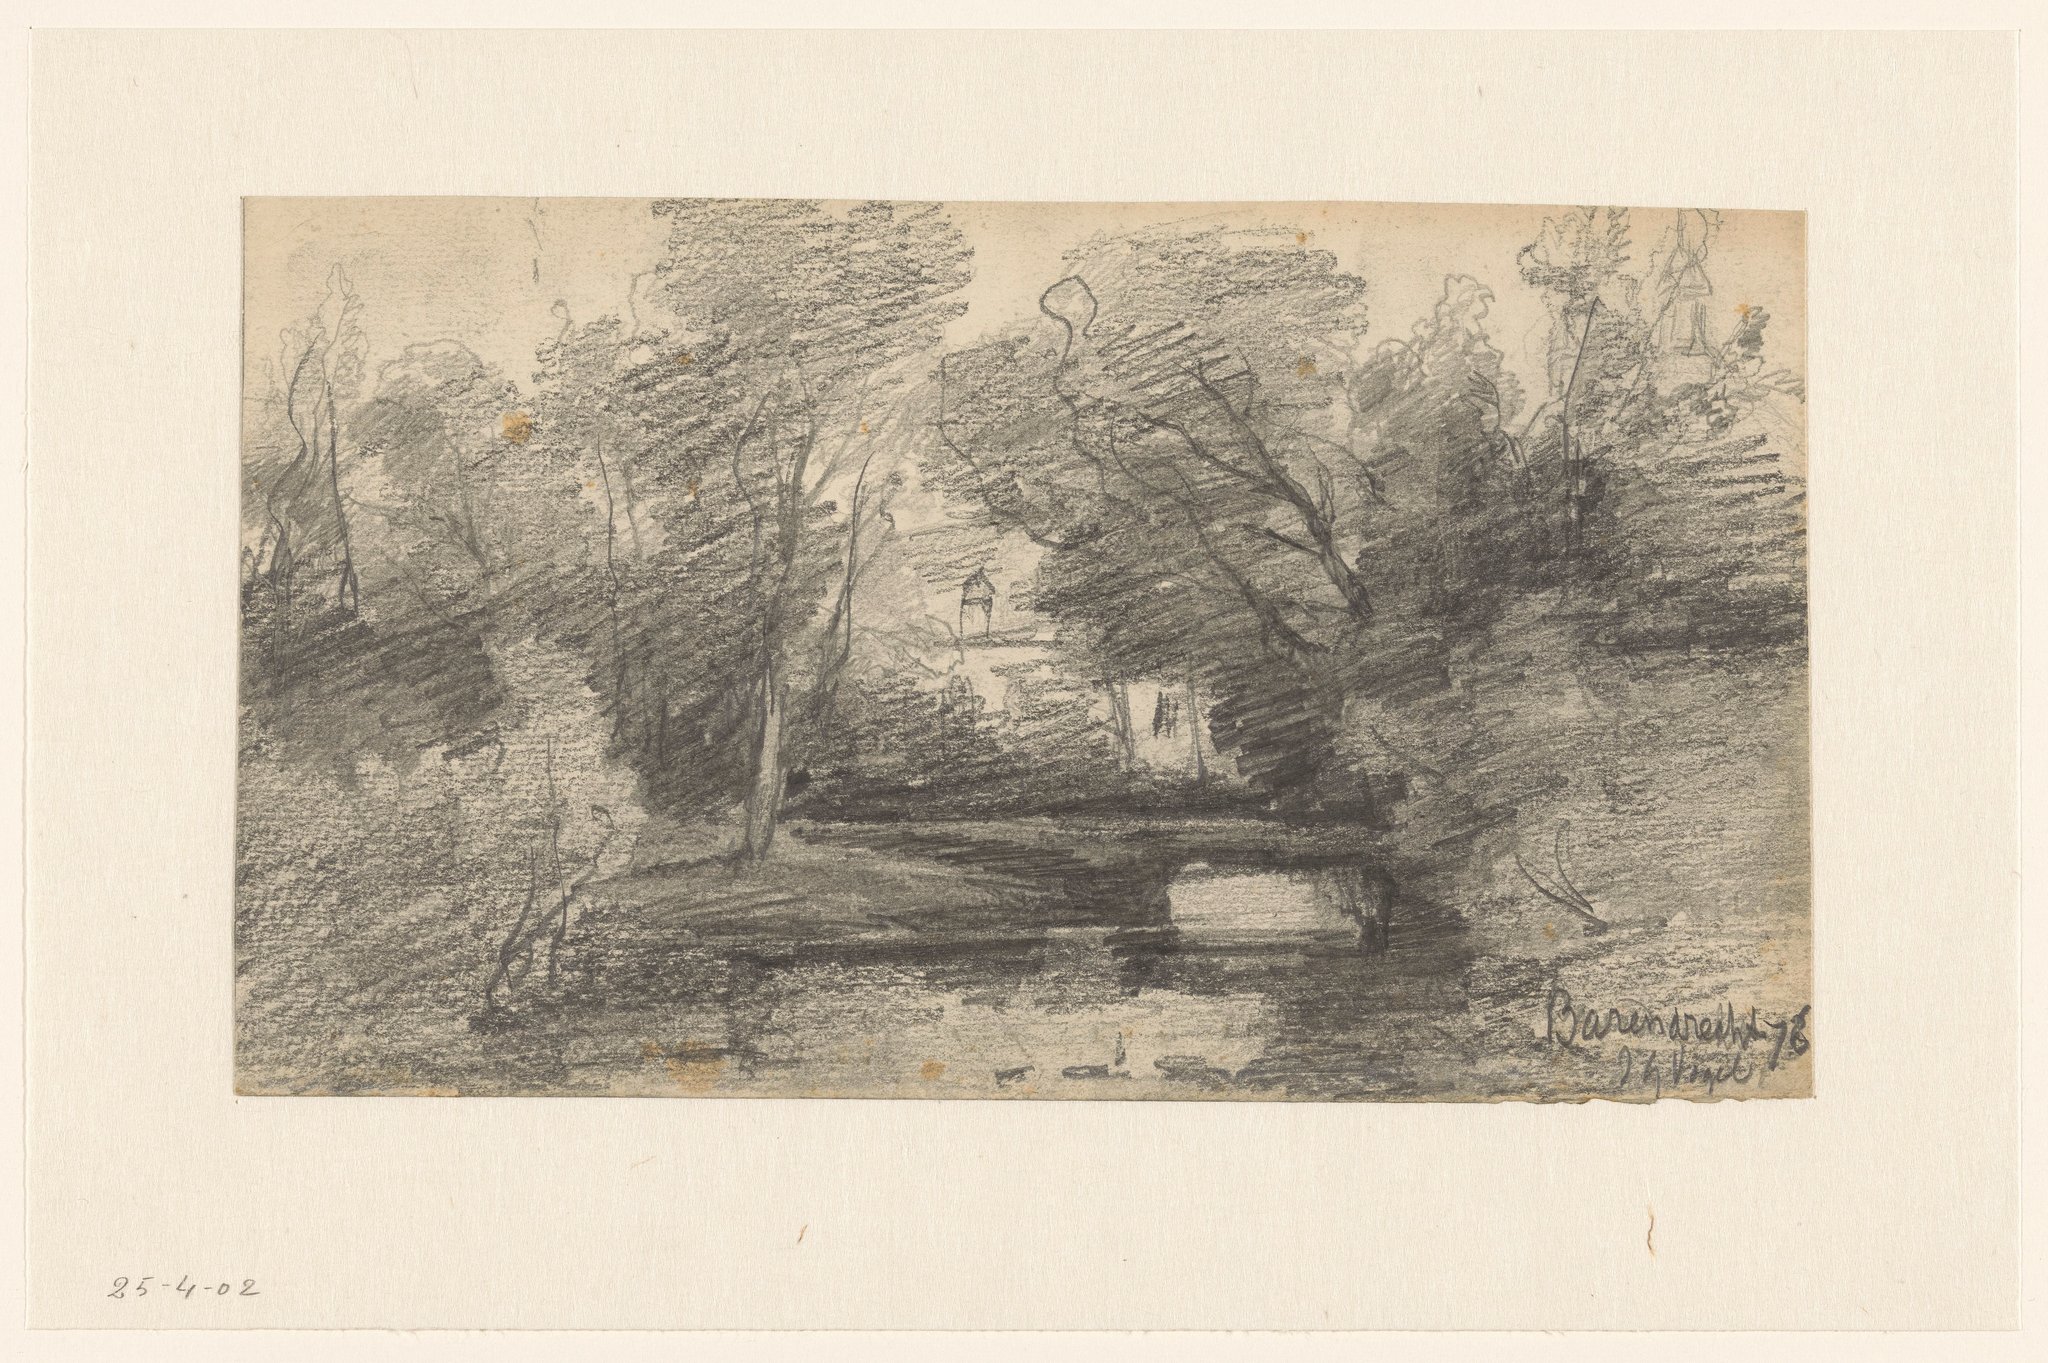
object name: drawing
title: Boslandschap met een bruggetje, Barendrecht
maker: johannes gijsbert vogel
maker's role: draughtsman, painter, print maker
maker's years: 1828-1915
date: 1876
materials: chalk, paper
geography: barendrecht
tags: meadow, pasture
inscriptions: date